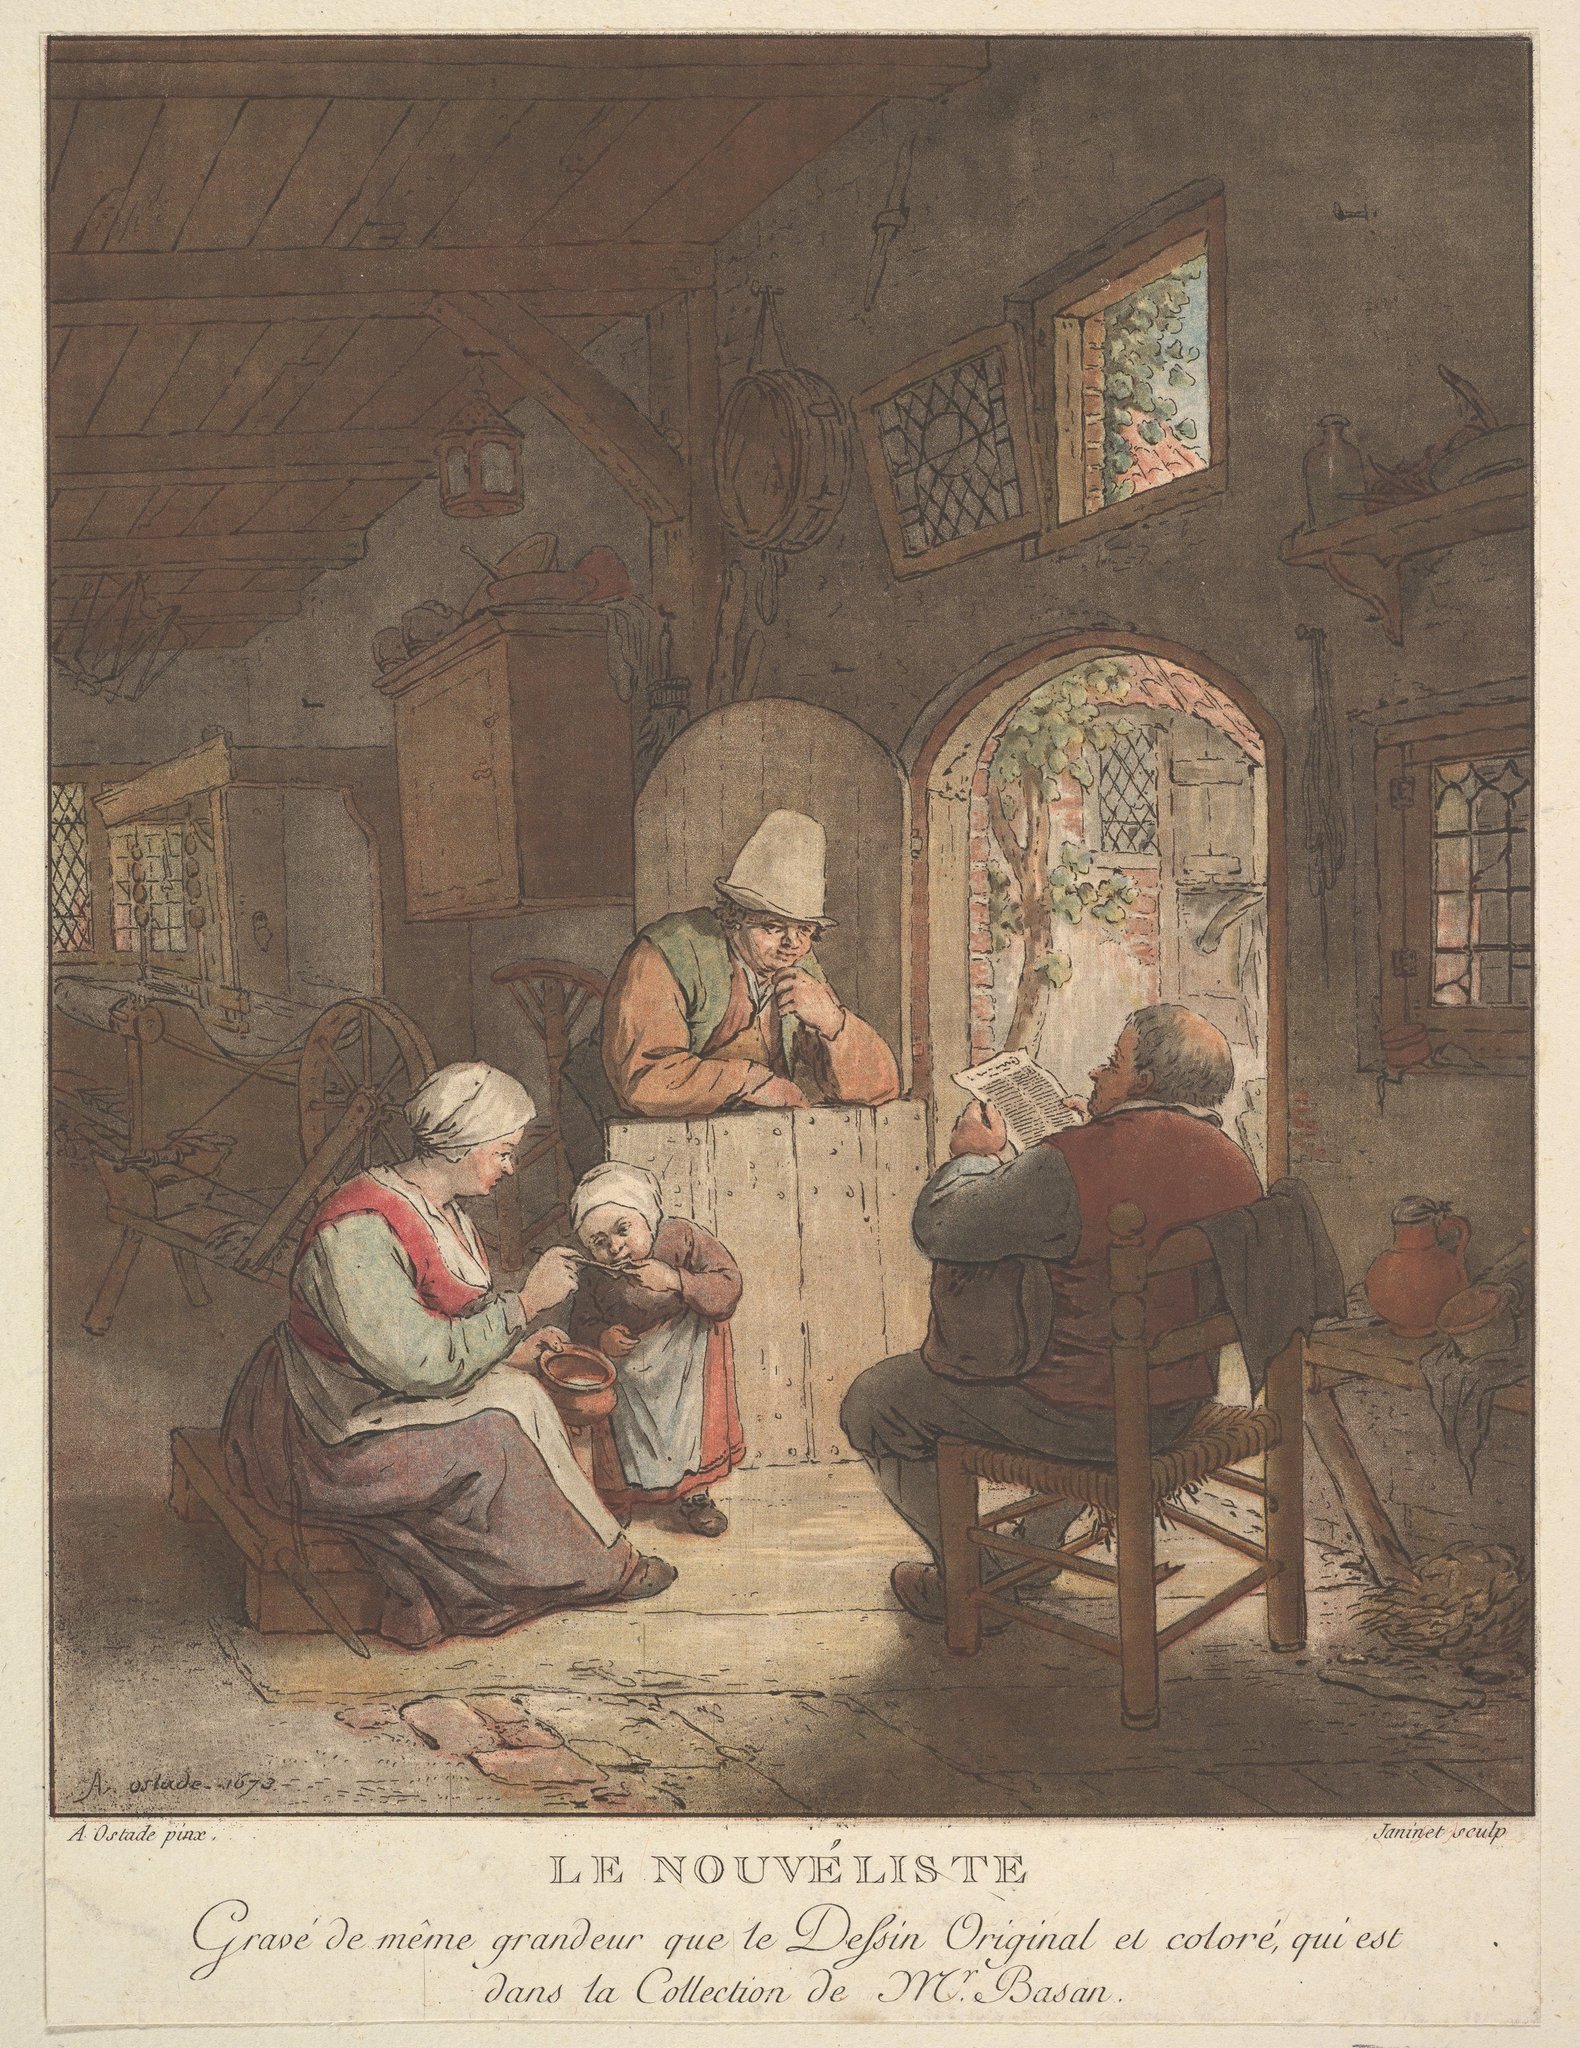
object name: print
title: Le Nouvéliste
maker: jean françois janinet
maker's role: artist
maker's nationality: french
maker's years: 1752-1814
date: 1770-1814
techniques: wash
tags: interiors,children,men,women,reading